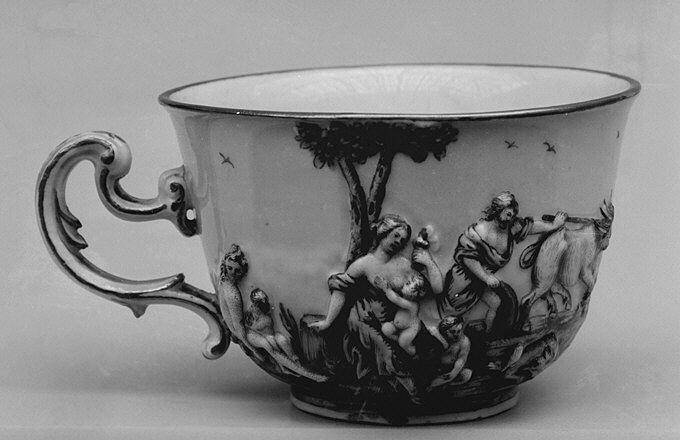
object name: teacup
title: Tea cup (part of a service)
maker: doccia porcelain manufactory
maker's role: manufactory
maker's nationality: italian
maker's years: 1737-1896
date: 1760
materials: hard paste porcelain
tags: animals,infants,women,trees